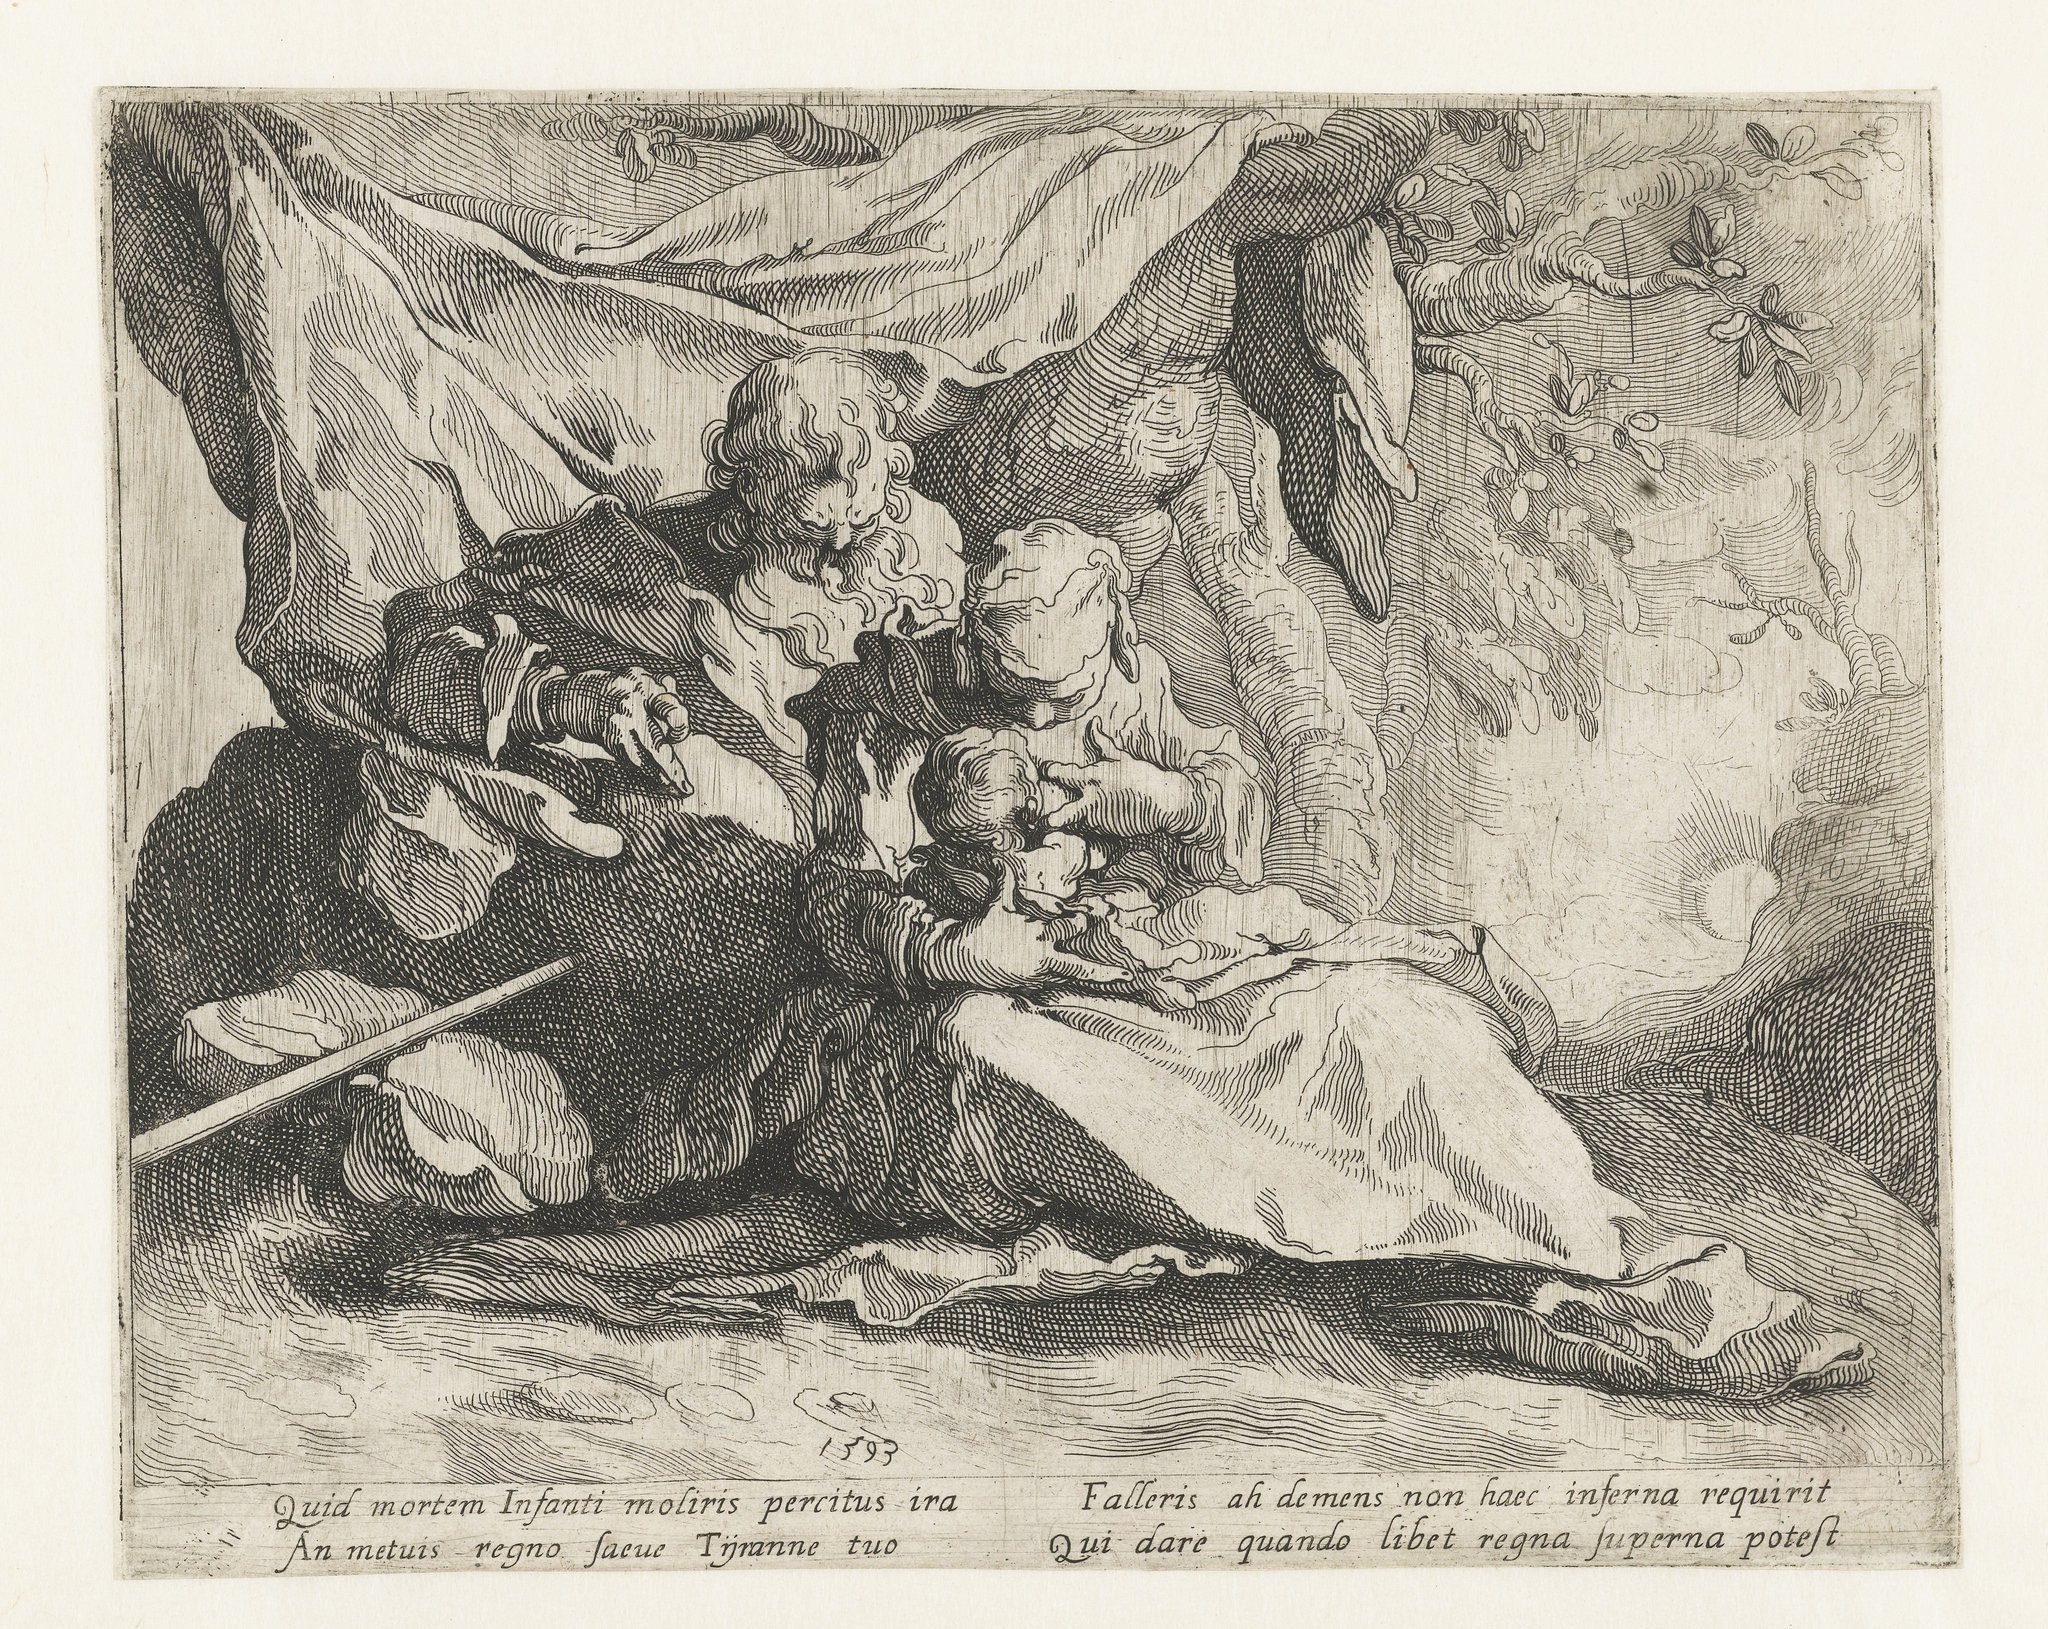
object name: print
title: Rest on the Flight into Egypt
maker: gerrit pietersz. sweelink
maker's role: draughtsman, painter, print maker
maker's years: 1566-1612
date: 1593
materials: paper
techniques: engraving, etching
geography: amsterdam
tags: rest on the flight into egypt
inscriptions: collector's mark: Lugt 240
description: De Heilige Familie rust bij een boom. Maria geeft het Christuskind de borst. Jozef kijkt toe.